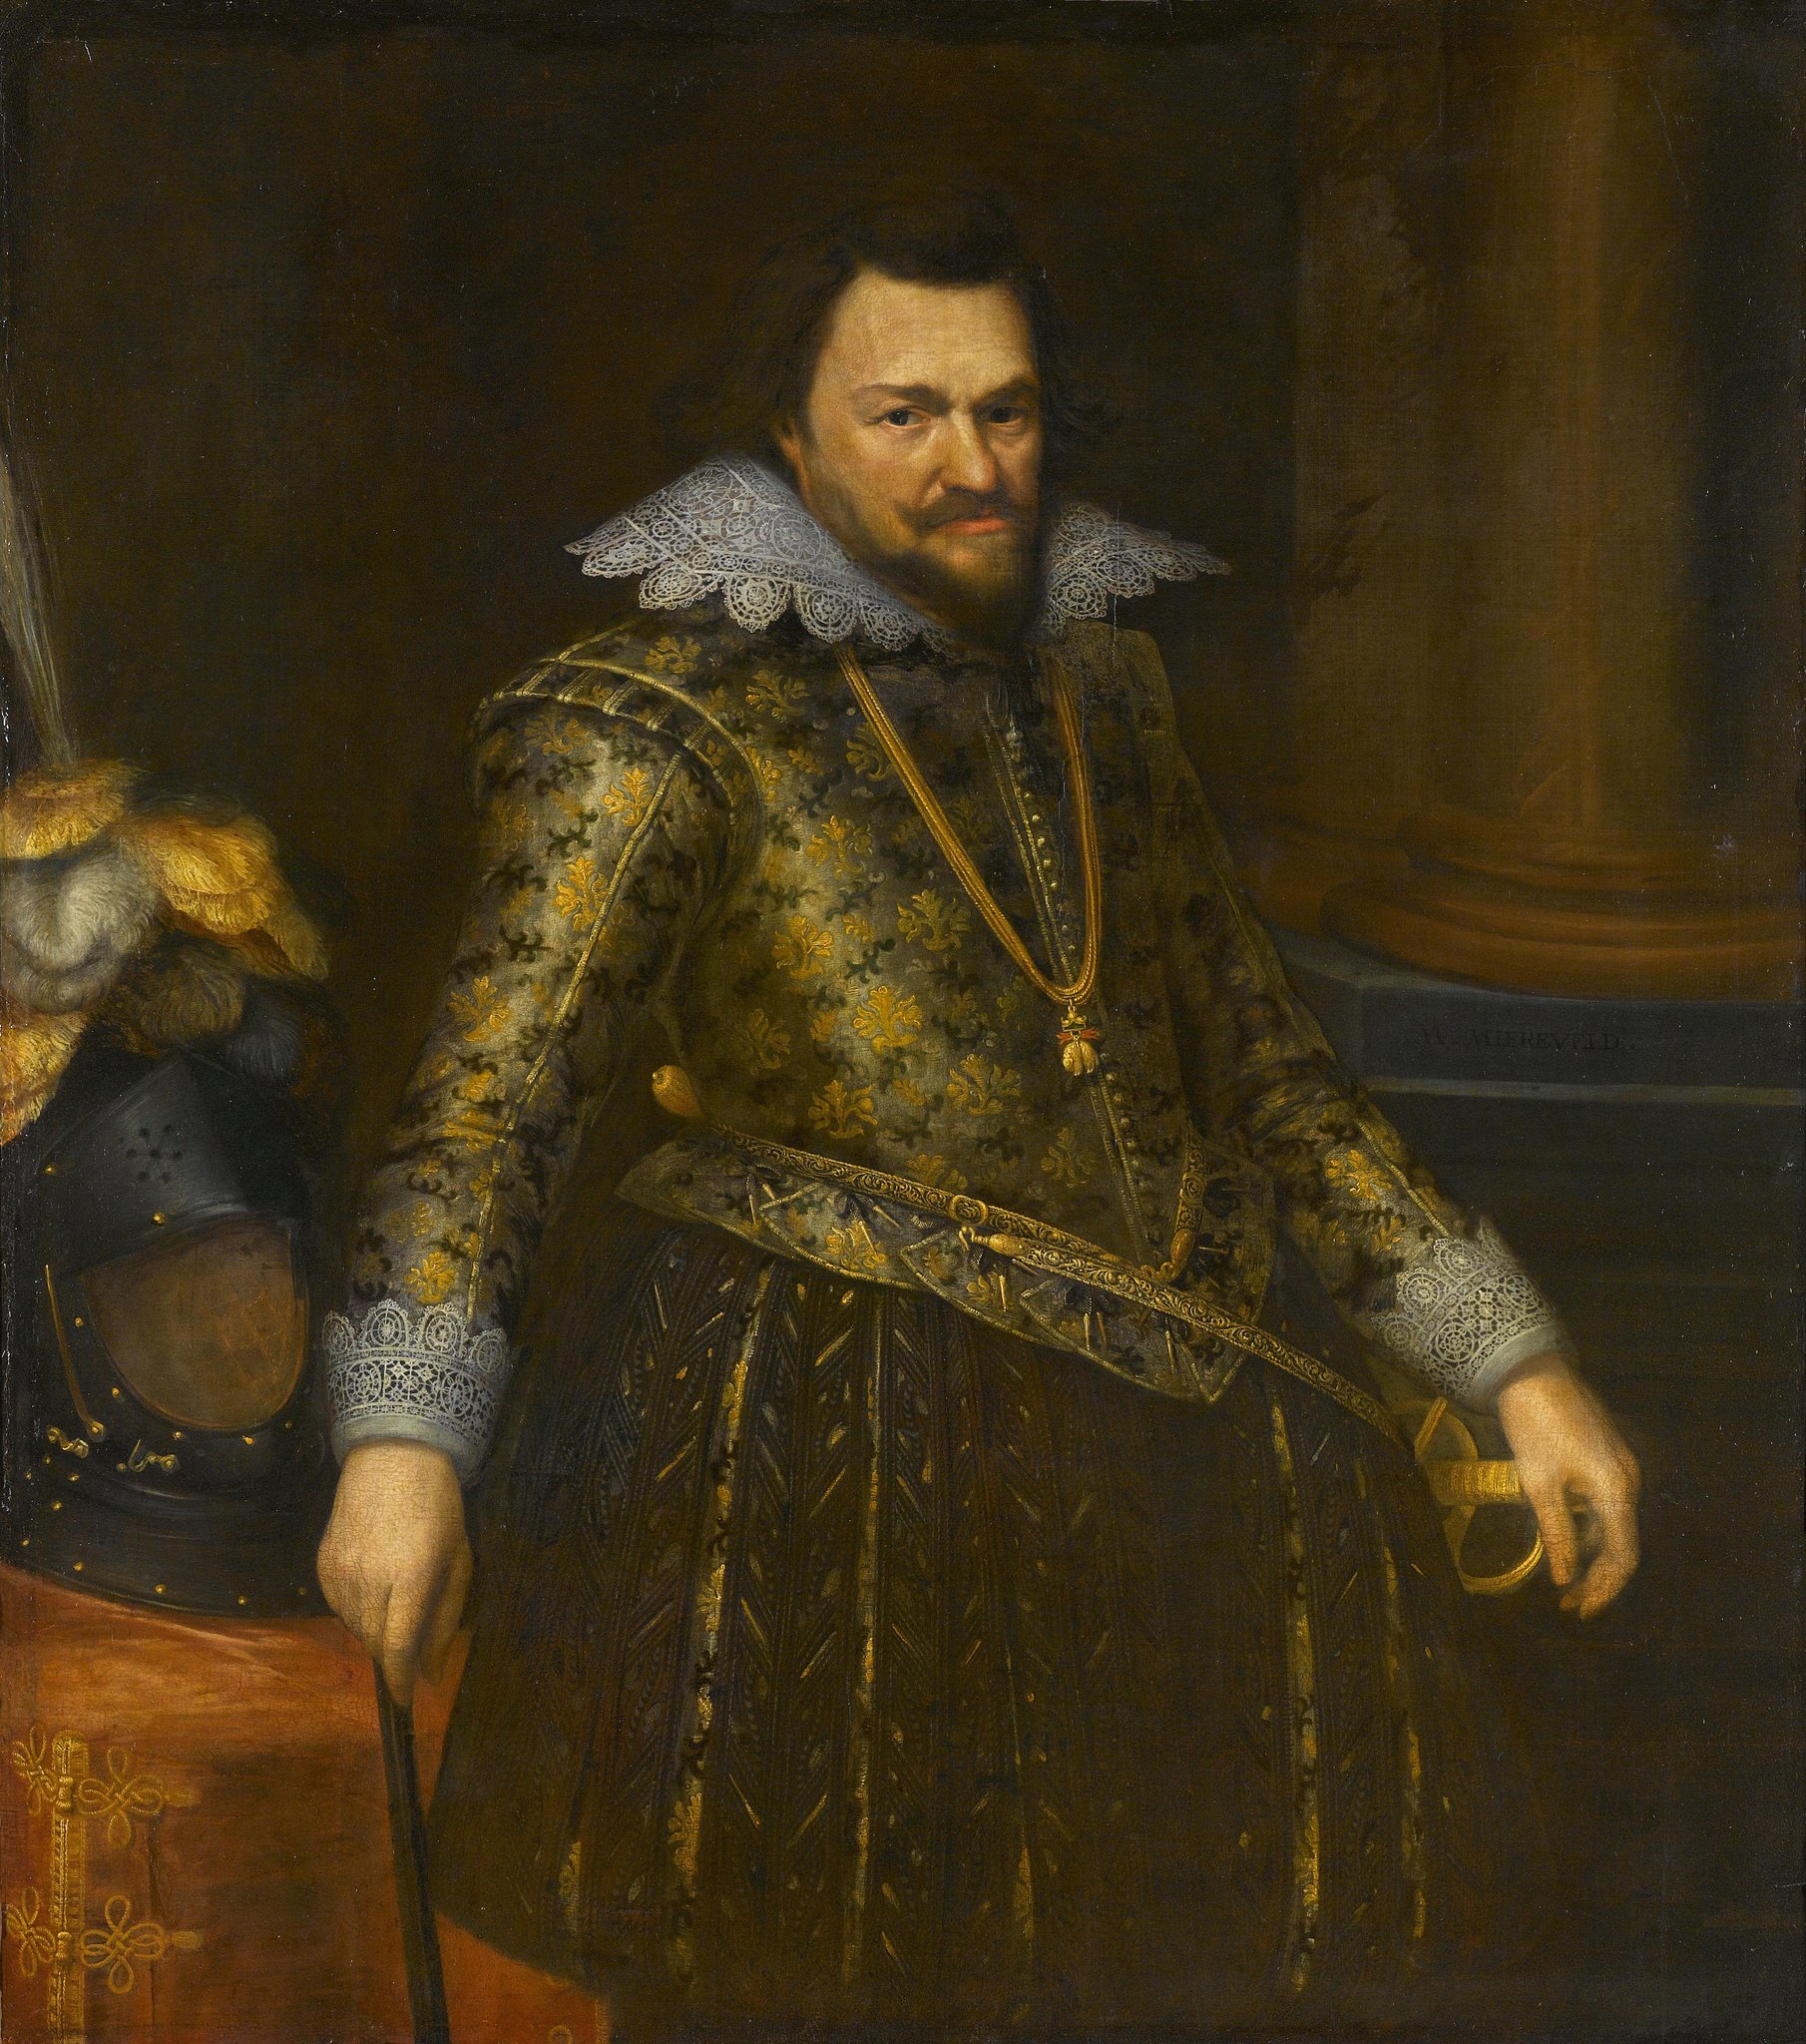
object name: painting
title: Portrait of Philips Willem (1554-1618), Prince of Orange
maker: michiel jansz van mierevelt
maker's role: draughtsman, painter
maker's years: 1567-1641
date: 1608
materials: canvas, oil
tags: buren, bruges, filips willem (prins van oranje), helmet, historical persons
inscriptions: signature, right, on the base of the column: ‘M. Miereveld’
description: Portret van Philips Willem, prins van Oranje, oudste zoon van Willem van Oranje. Staand, kniestuk, de rechterhand op een wandelstok, de linkerhand rustend op het gevest van zijn zwaard. Links de helm op een tafel.